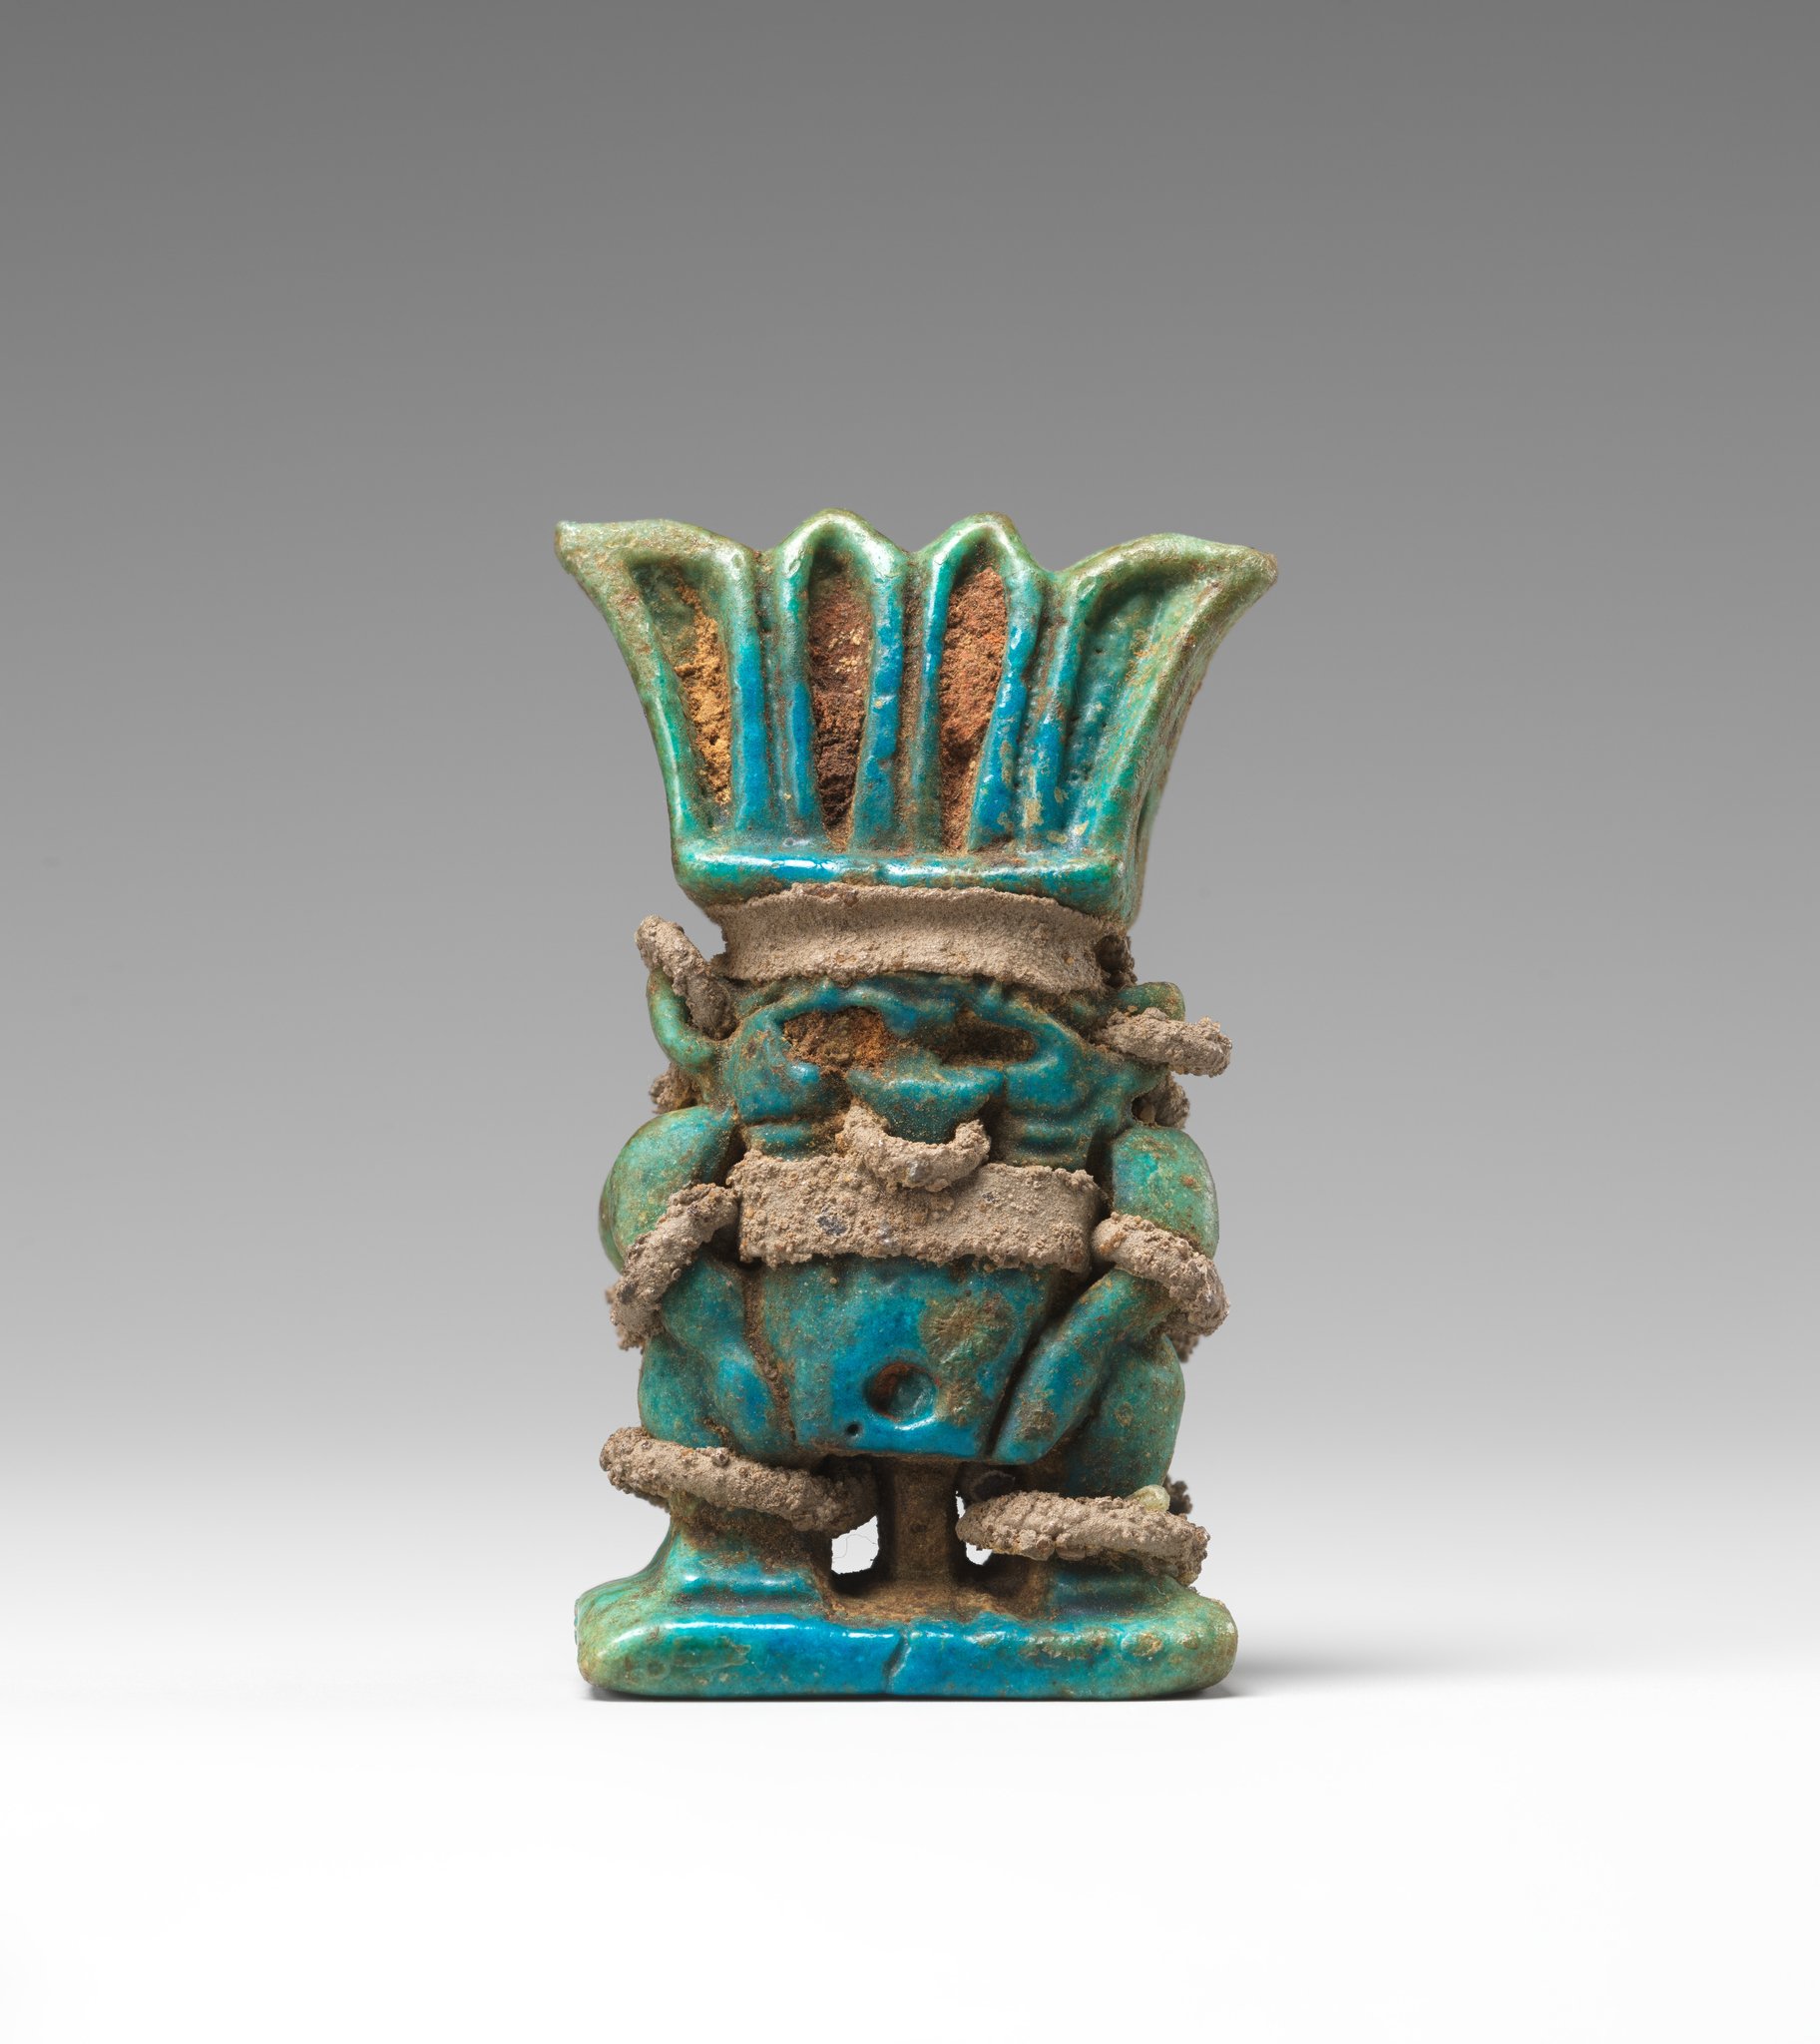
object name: amulet, be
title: Amulet with twinned Bes-images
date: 1295-700 BCE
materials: faience, silver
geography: egypt